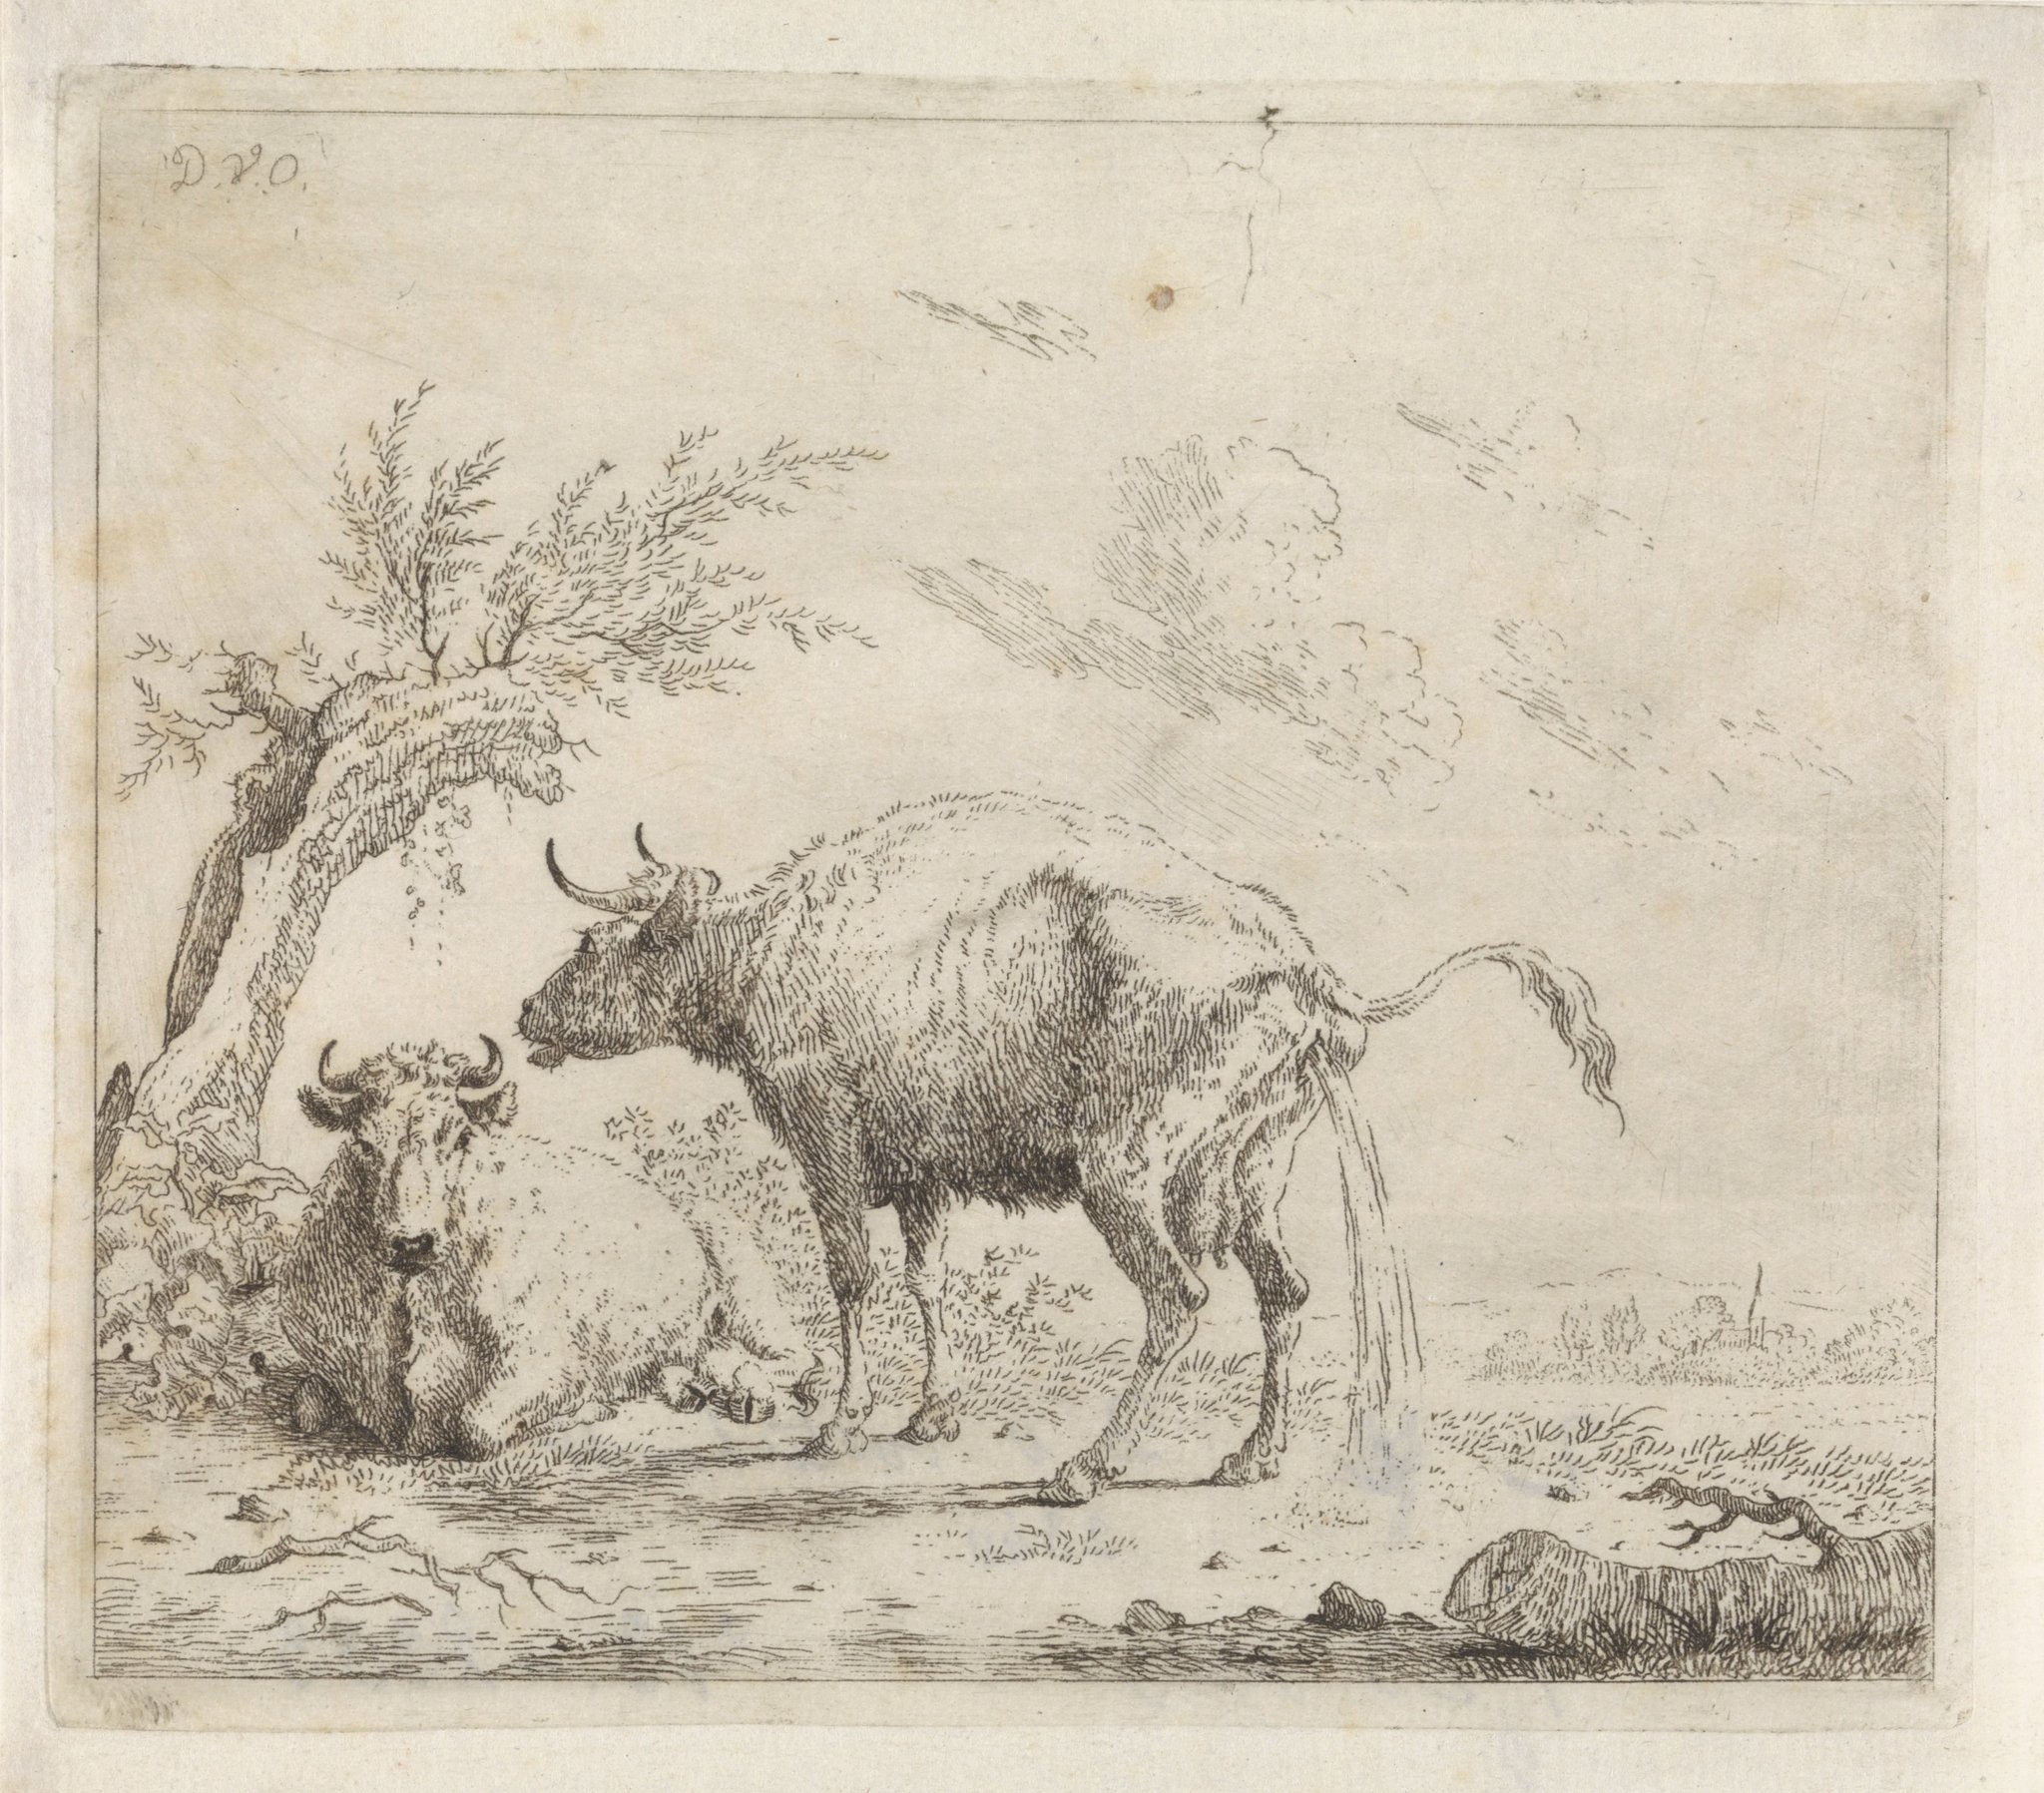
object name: print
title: Landschap met twee koeien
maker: dirk van oosterhoudt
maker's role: draughtsman, painter, print maker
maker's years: 1756-1830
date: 1766-1830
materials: paper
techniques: etching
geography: tiel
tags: cow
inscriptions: collector's mark: Lugt 2228